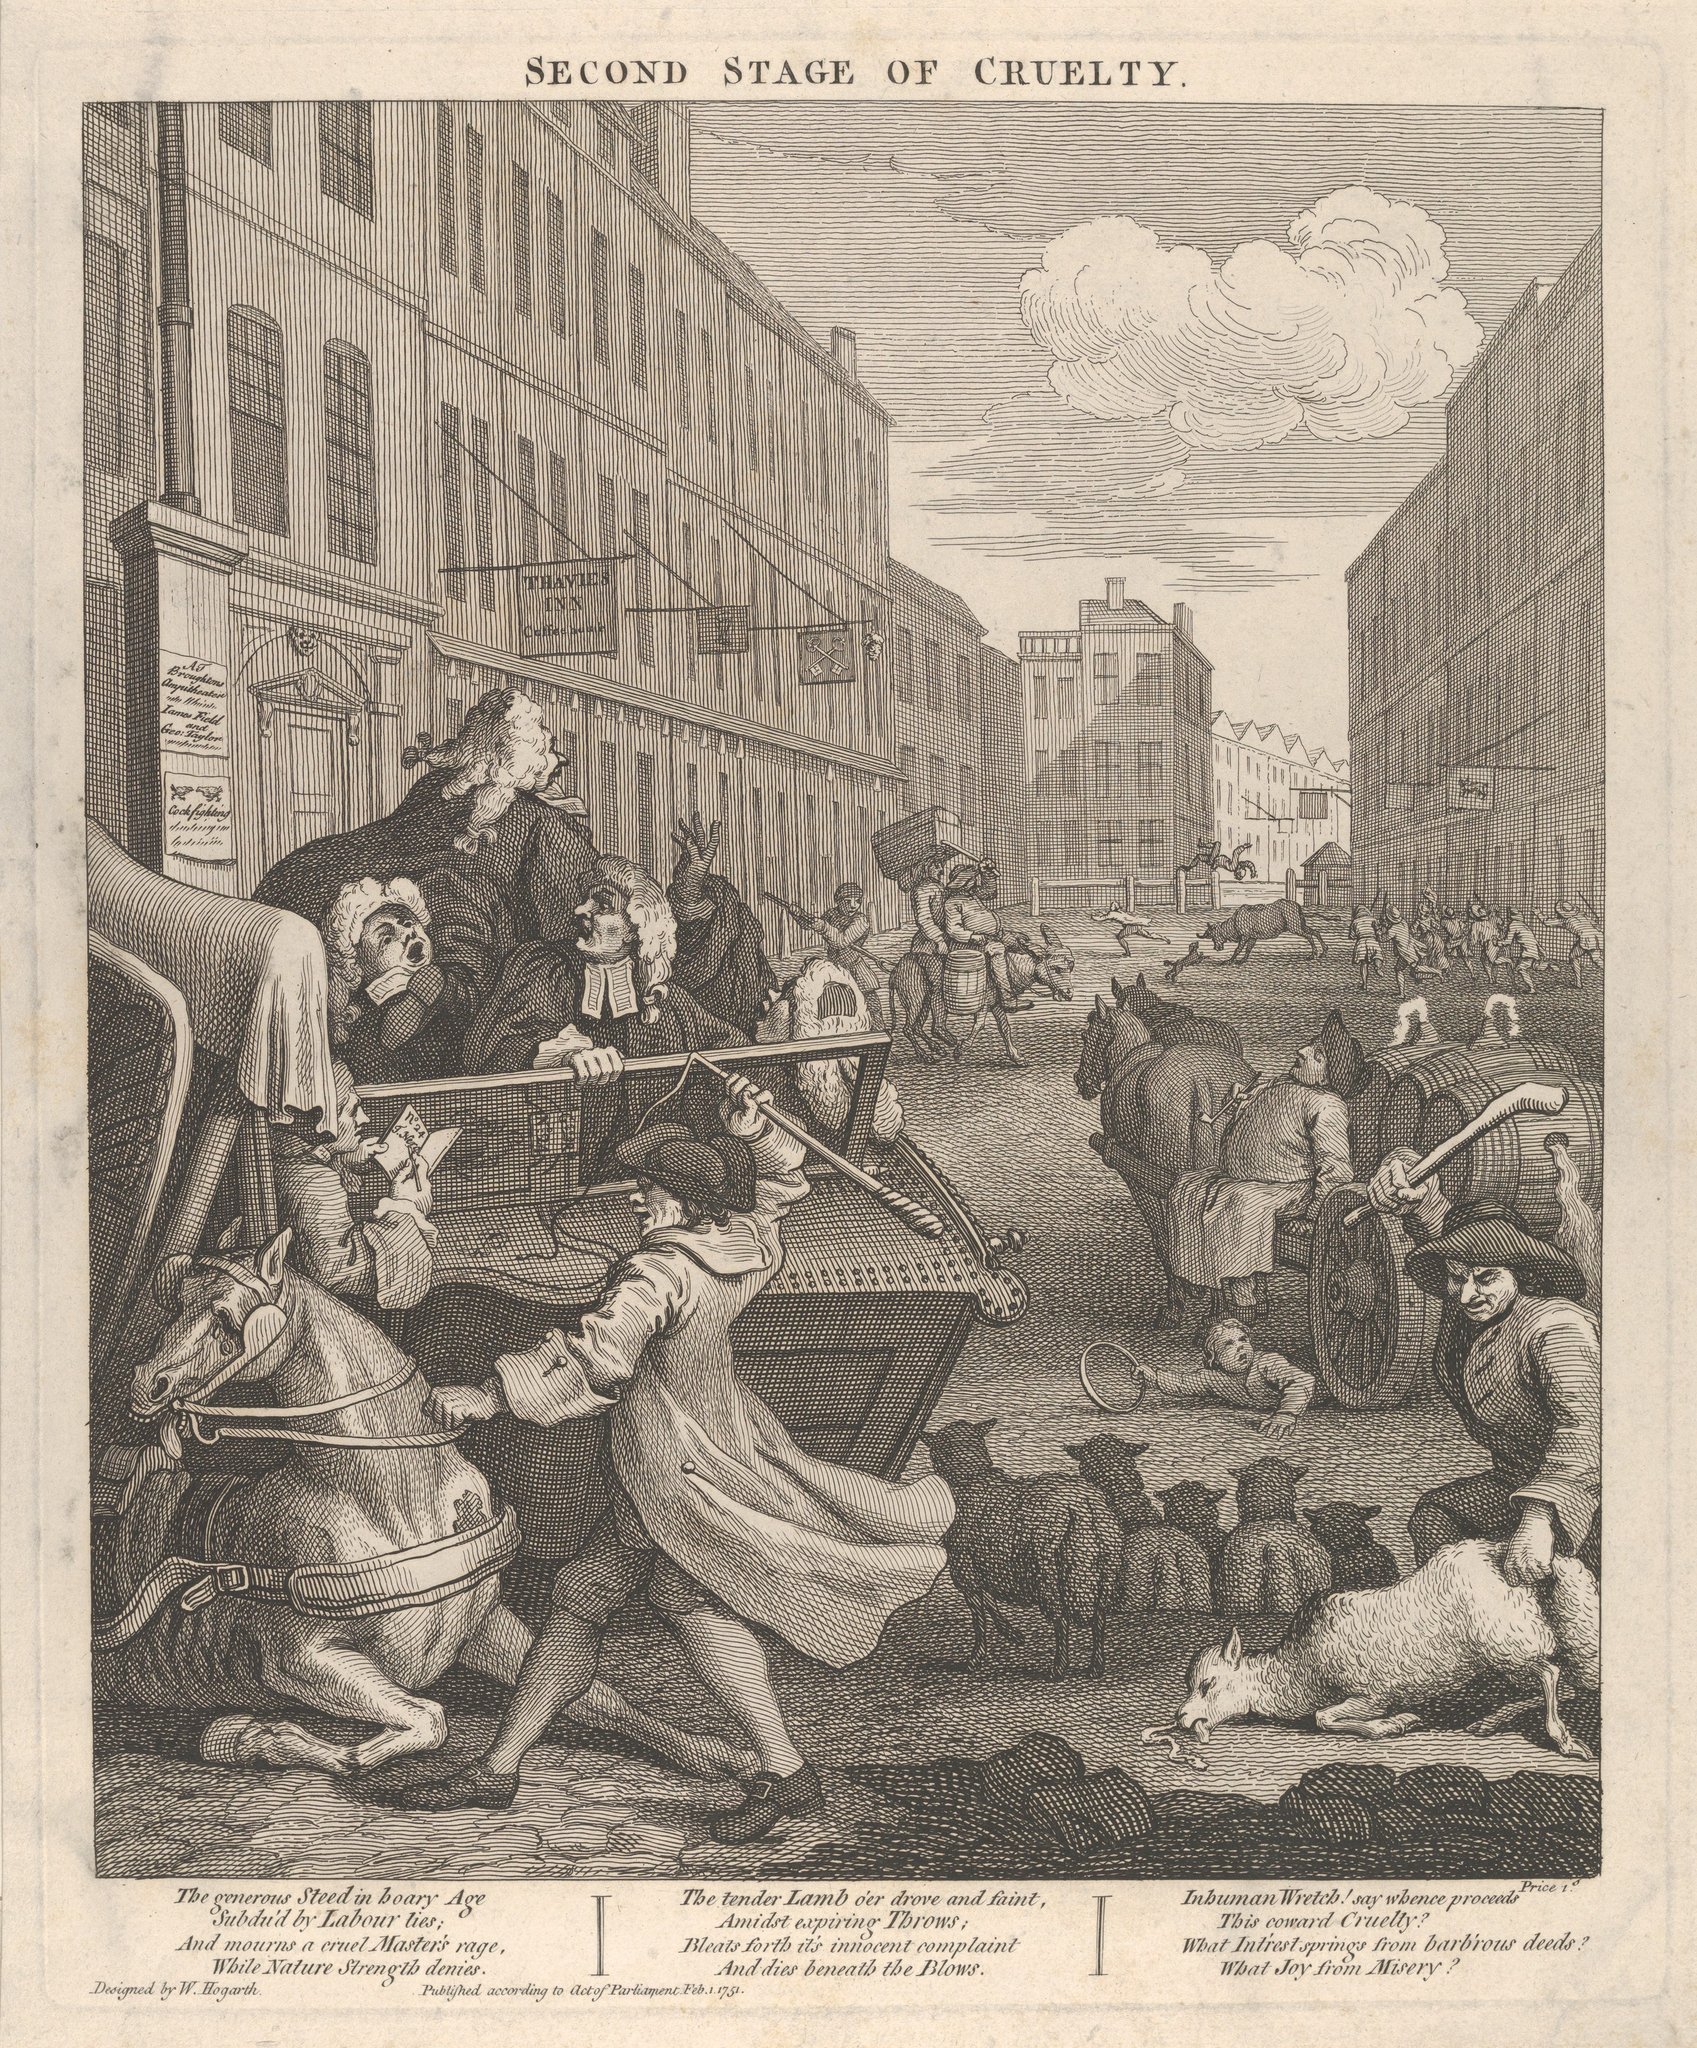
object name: print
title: The Second Stage of Cruelty (The Four Stages of Cruelty)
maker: william hogarth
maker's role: artist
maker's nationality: british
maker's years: 1697-1764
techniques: engraving, etching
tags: animals,buildings,men,carriages